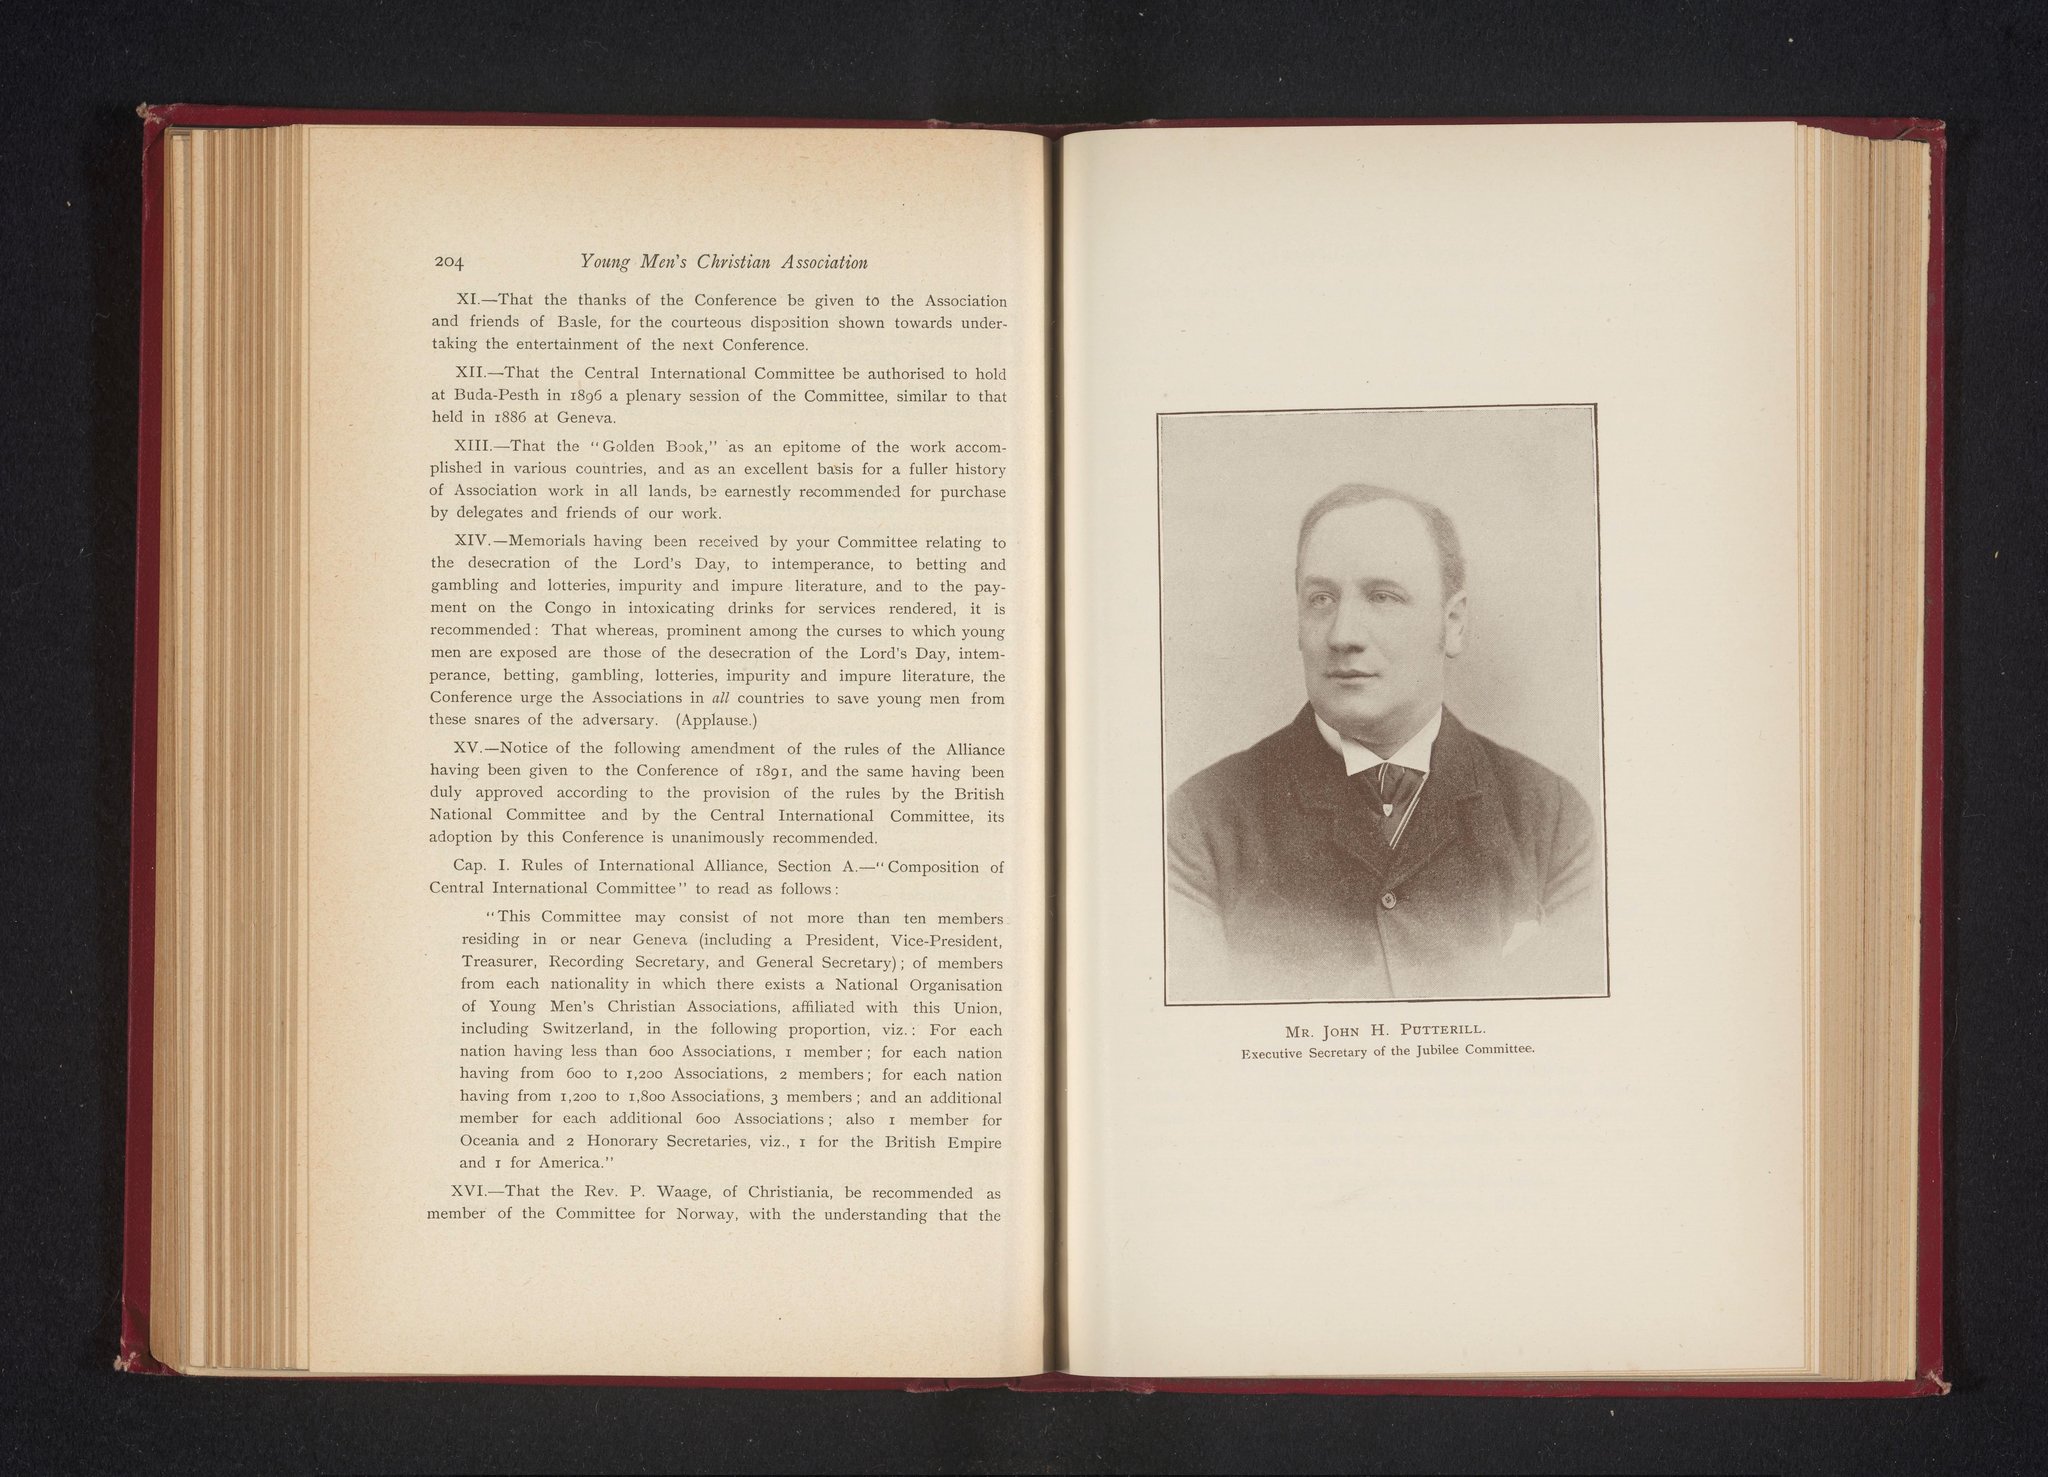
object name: page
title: Mr. John H. Putterill. Executive Secretary of the Jubilee Committee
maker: Anonymous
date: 1890-1895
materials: paper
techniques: autotype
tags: historical persons